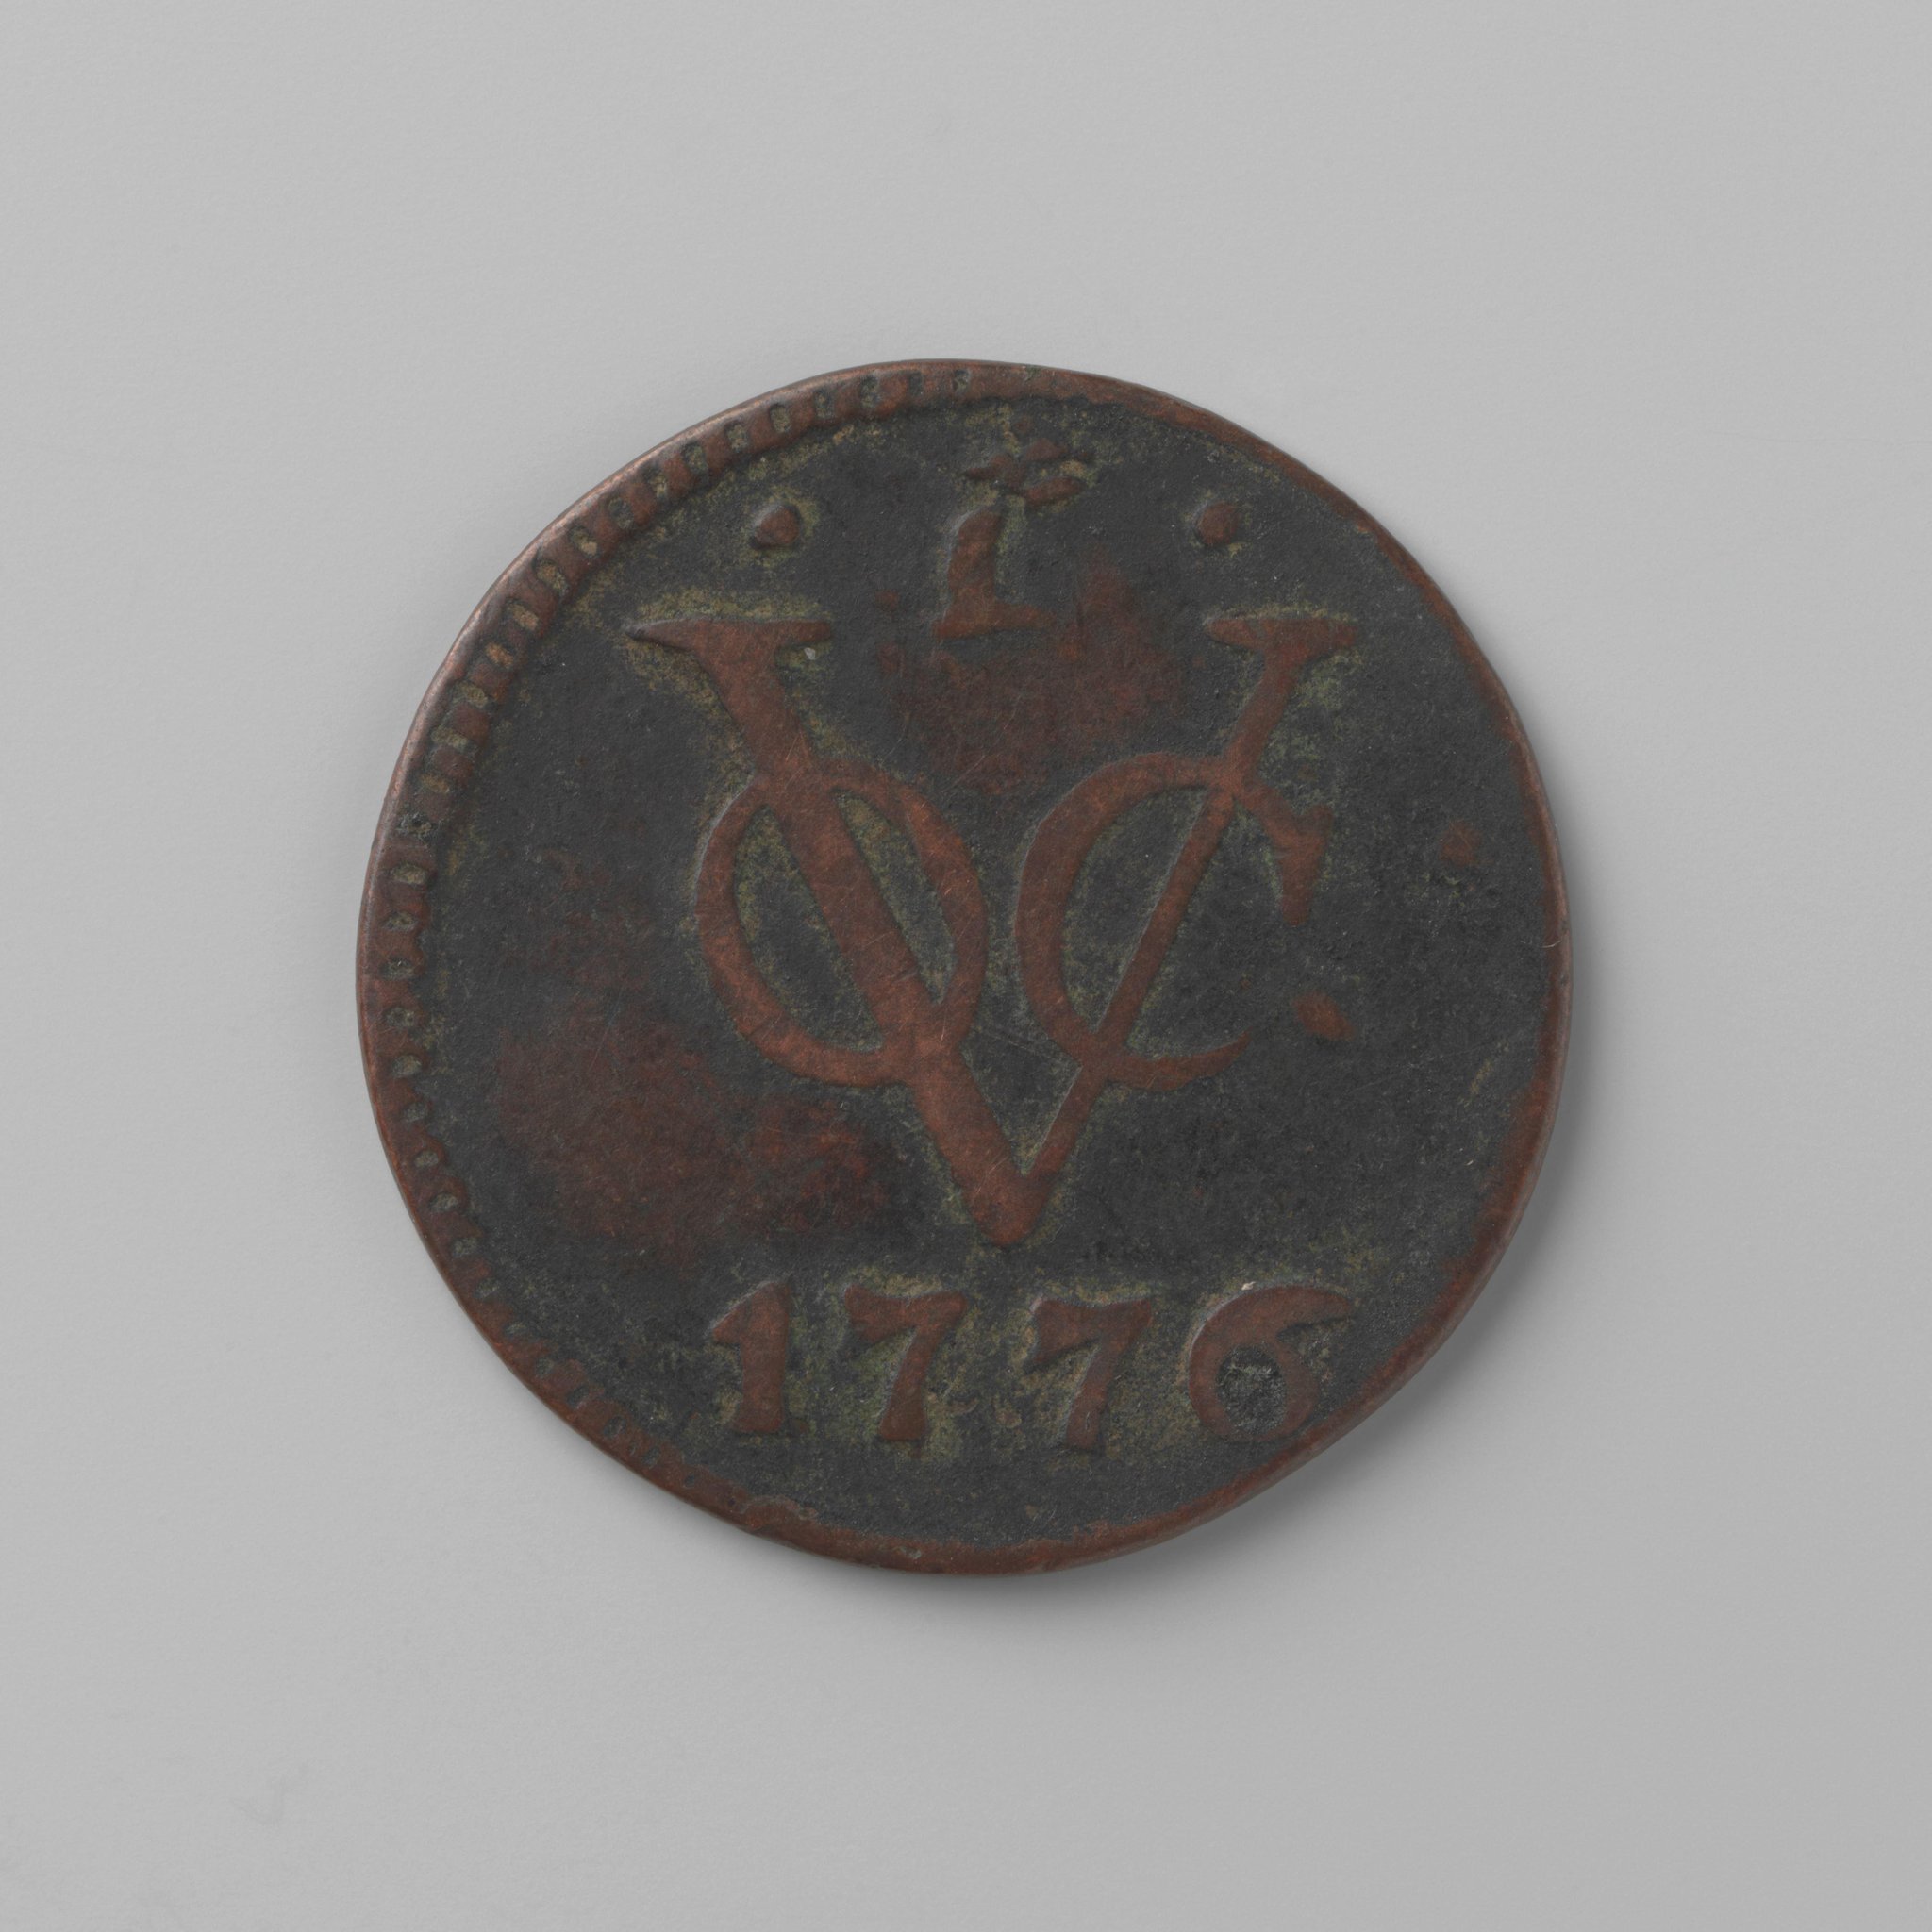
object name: coin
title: Duit van de VOC uit Gelderland,1776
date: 1776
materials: copper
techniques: striking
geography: harderwijk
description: Koperen munt. Voorzijde: tussen wapenspreuk gekroond wapenschild van Gelderland. Keerzijde: monogram van de VOC, waarboven muntmeesterteken en waaronder jaartal. Gladde rand.